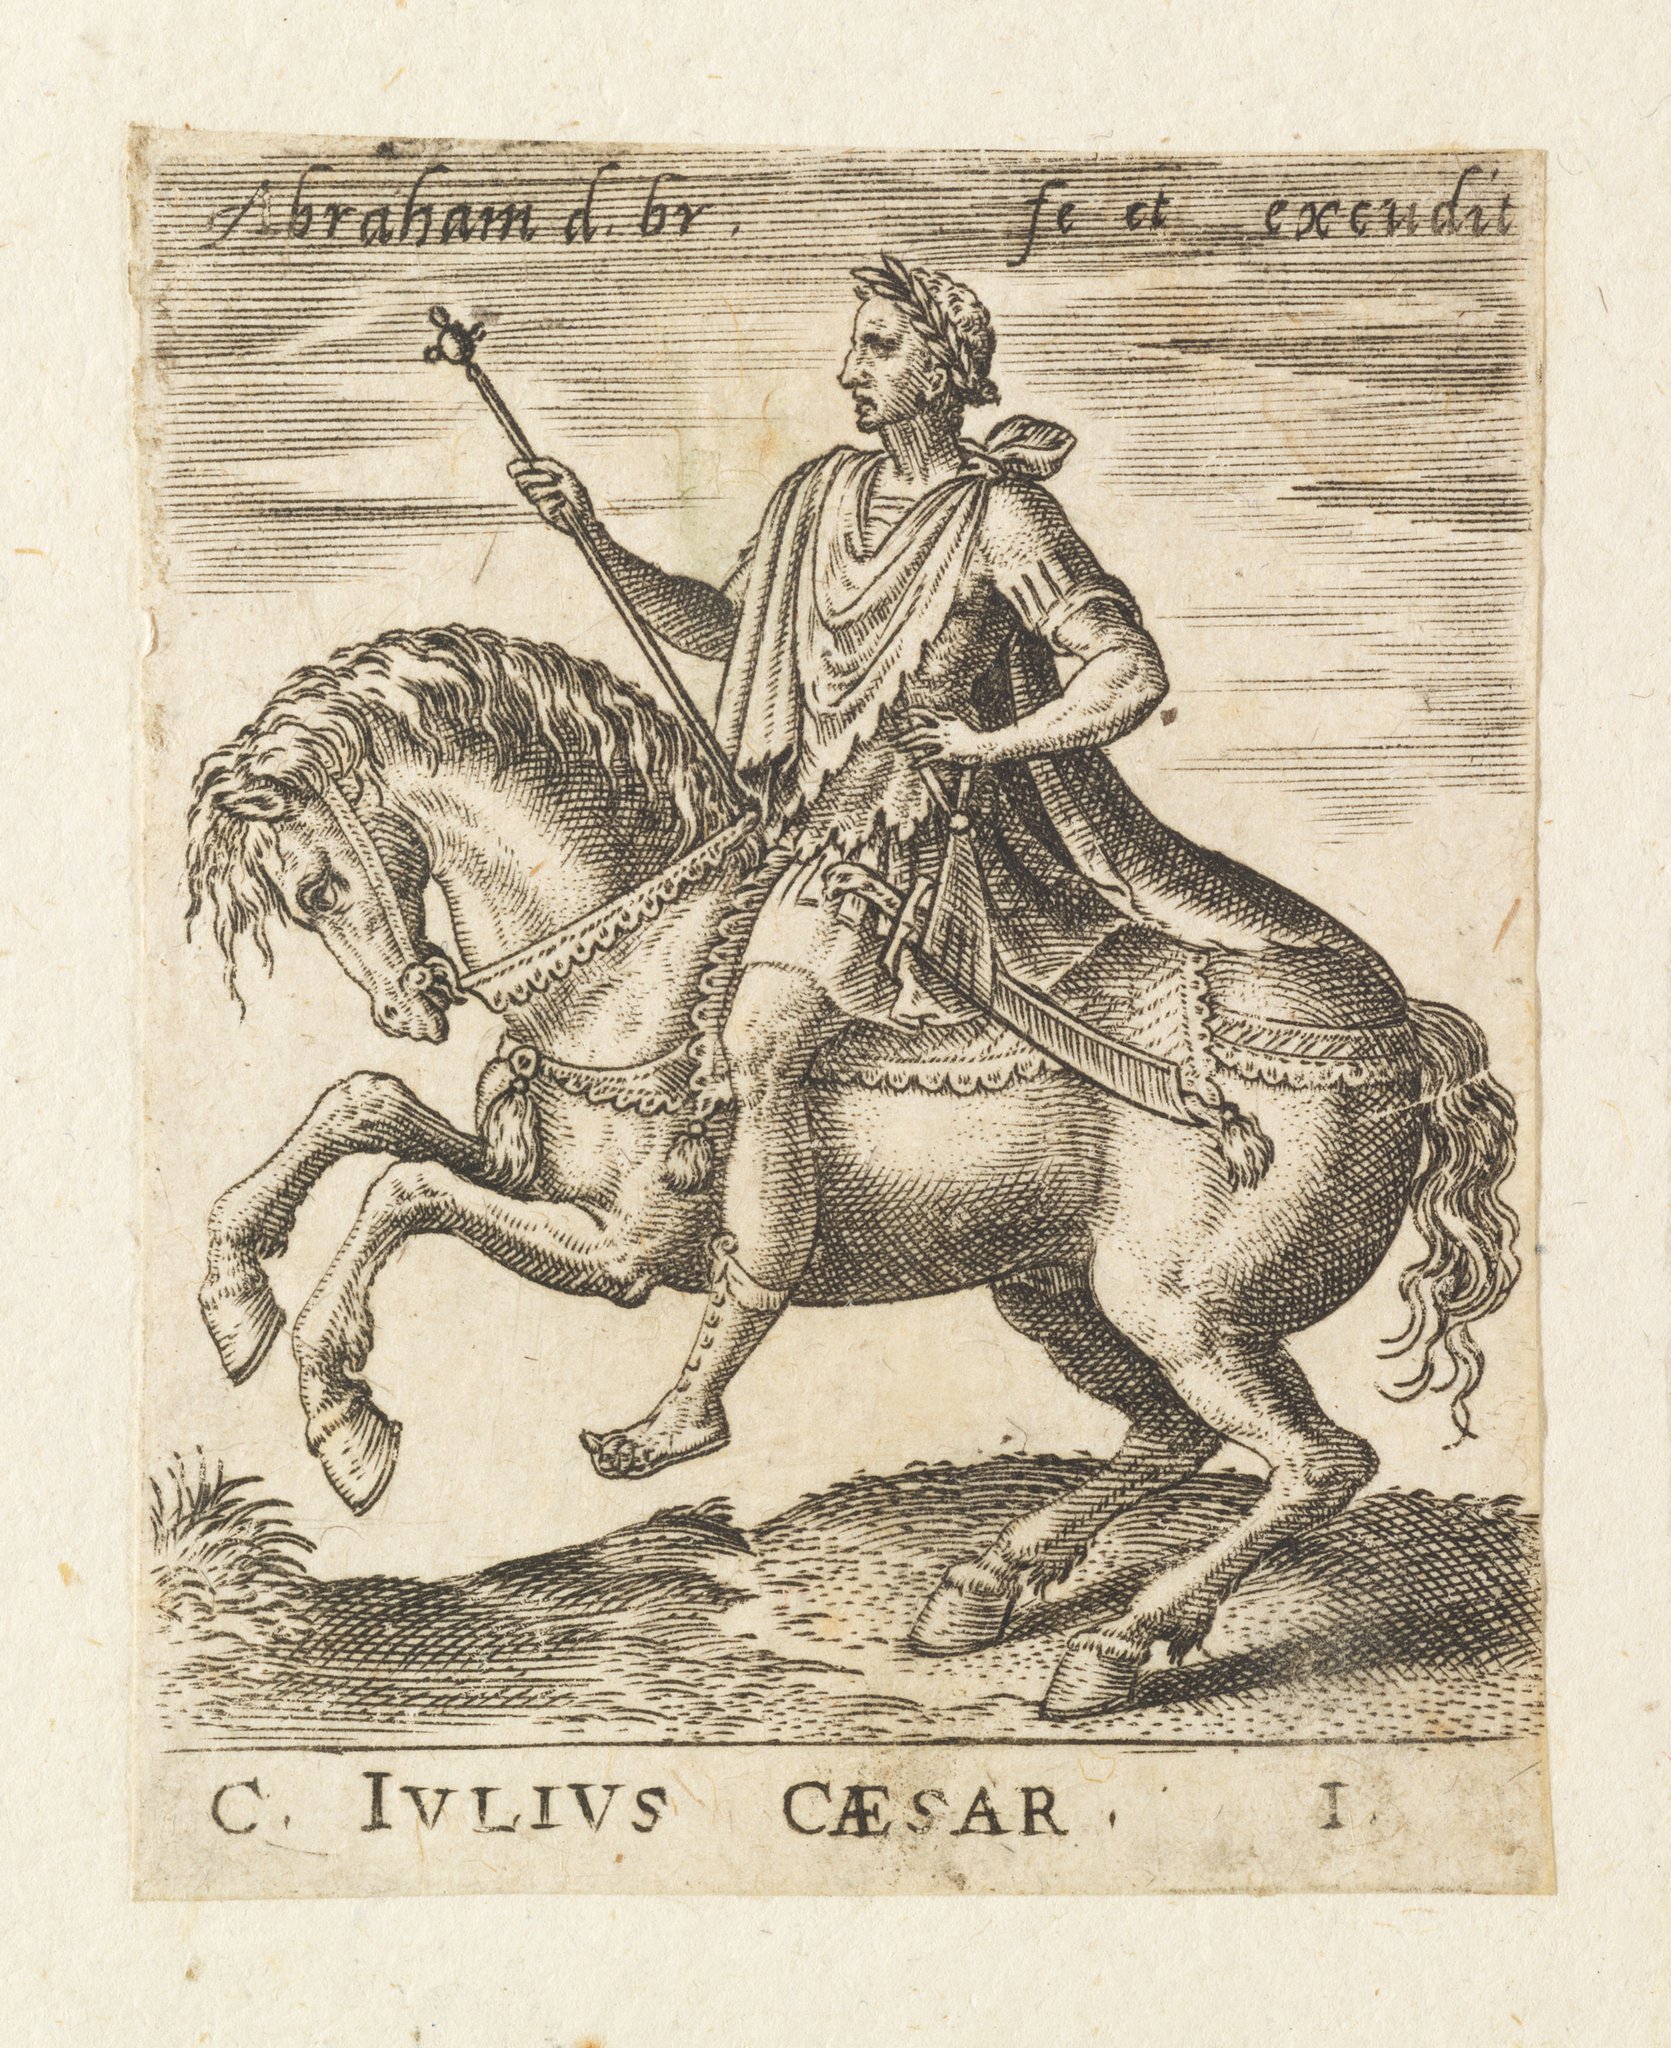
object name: print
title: C. Julius Caesar, from "Twelve Caesars on Horseback"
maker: abraham de bruyn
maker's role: artist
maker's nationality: flemish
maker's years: 1540-1587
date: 1565-1587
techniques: engraving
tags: julius caesar,horses